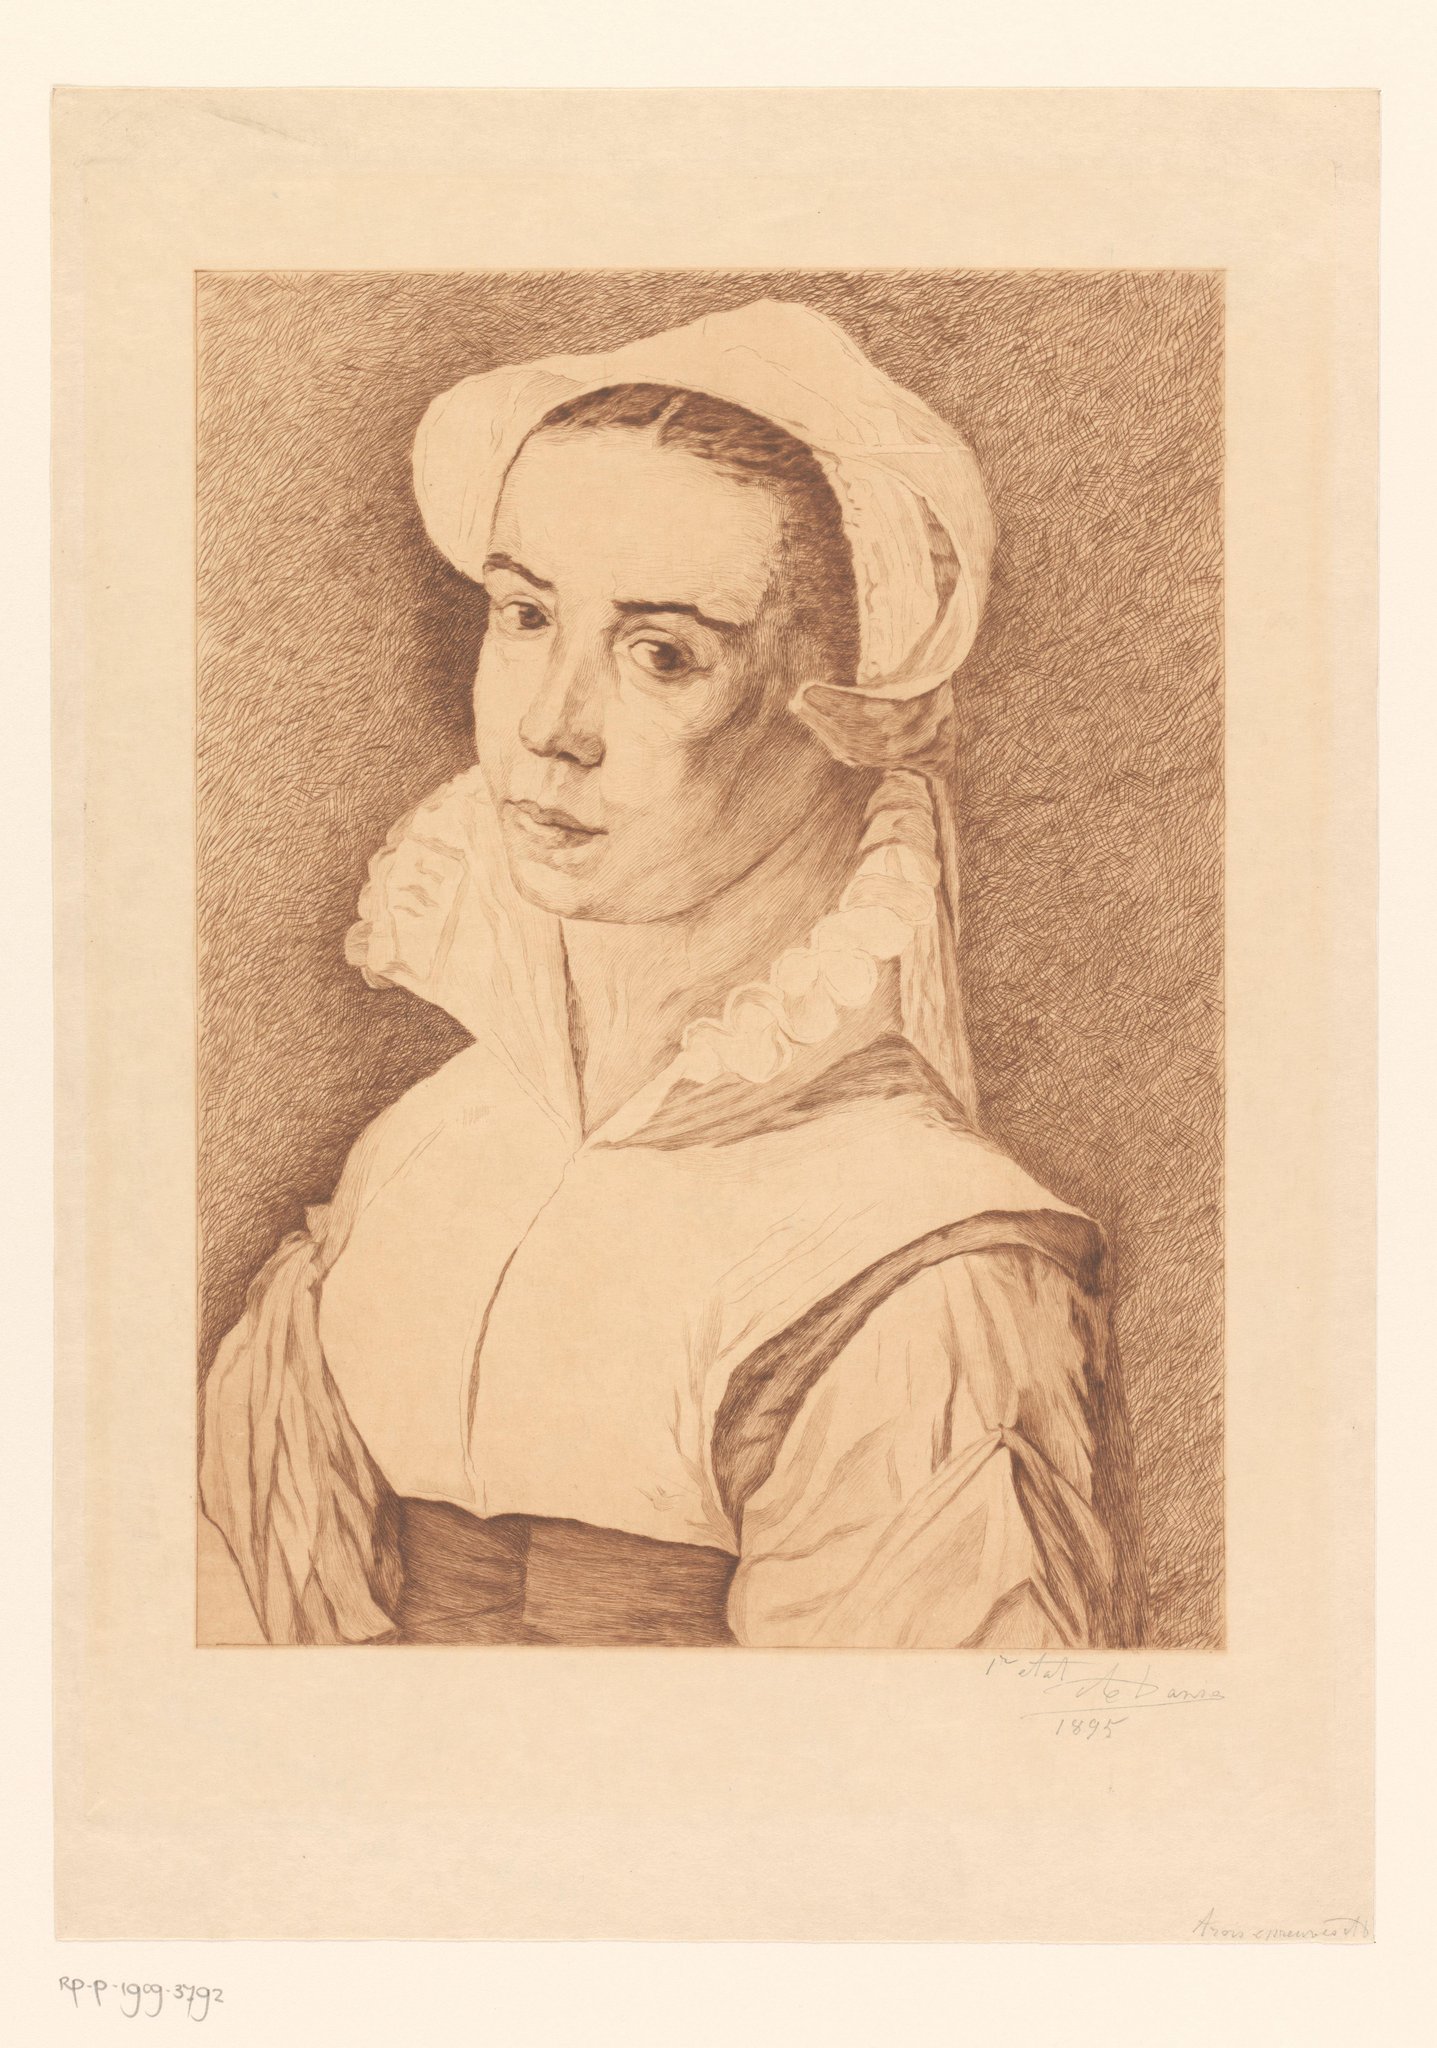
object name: print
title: Portret van een onbekende jonge vrouw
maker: auguste danse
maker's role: print maker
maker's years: 1829-1929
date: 1895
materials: paper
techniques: drypoint, etching, intaglio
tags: adolescent, young woman, maiden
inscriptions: annotation: ‘1er etat; trois epreuves’, collector's mark: Lugt 2228